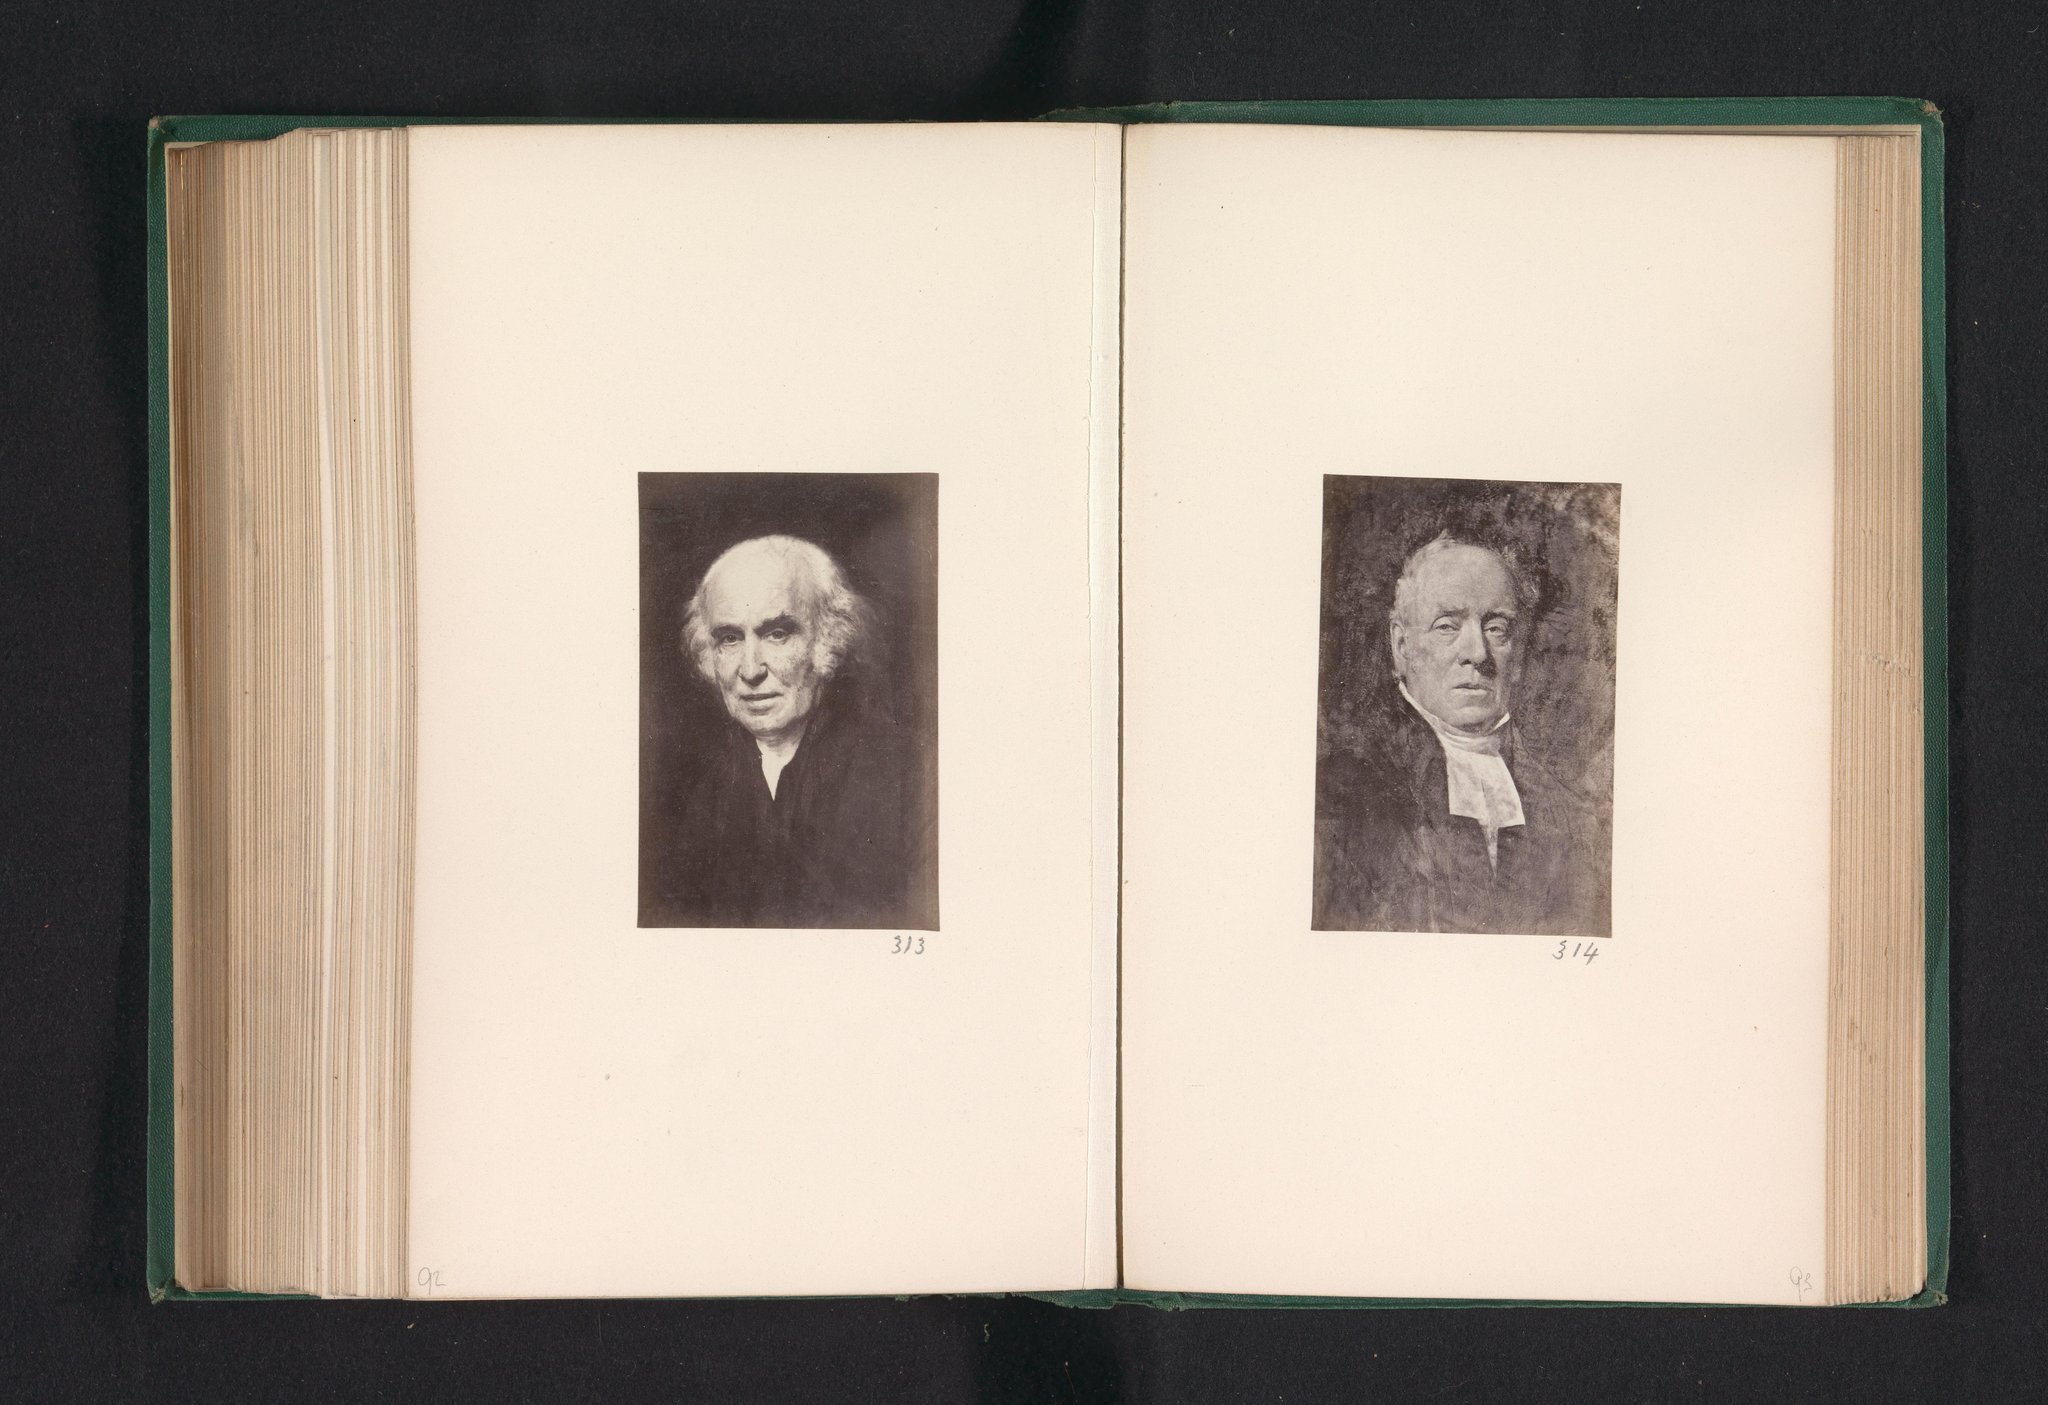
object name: photograph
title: Fotoreproductie van een schilderij, voorstellende een portret van John Burns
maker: thomas annan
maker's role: fotograaf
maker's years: 1829-1887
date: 1863-1868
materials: photographic support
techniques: albumen print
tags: historical persons (portraits and scenes from the life) (+ (full) bust portrait)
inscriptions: number: ‘313’